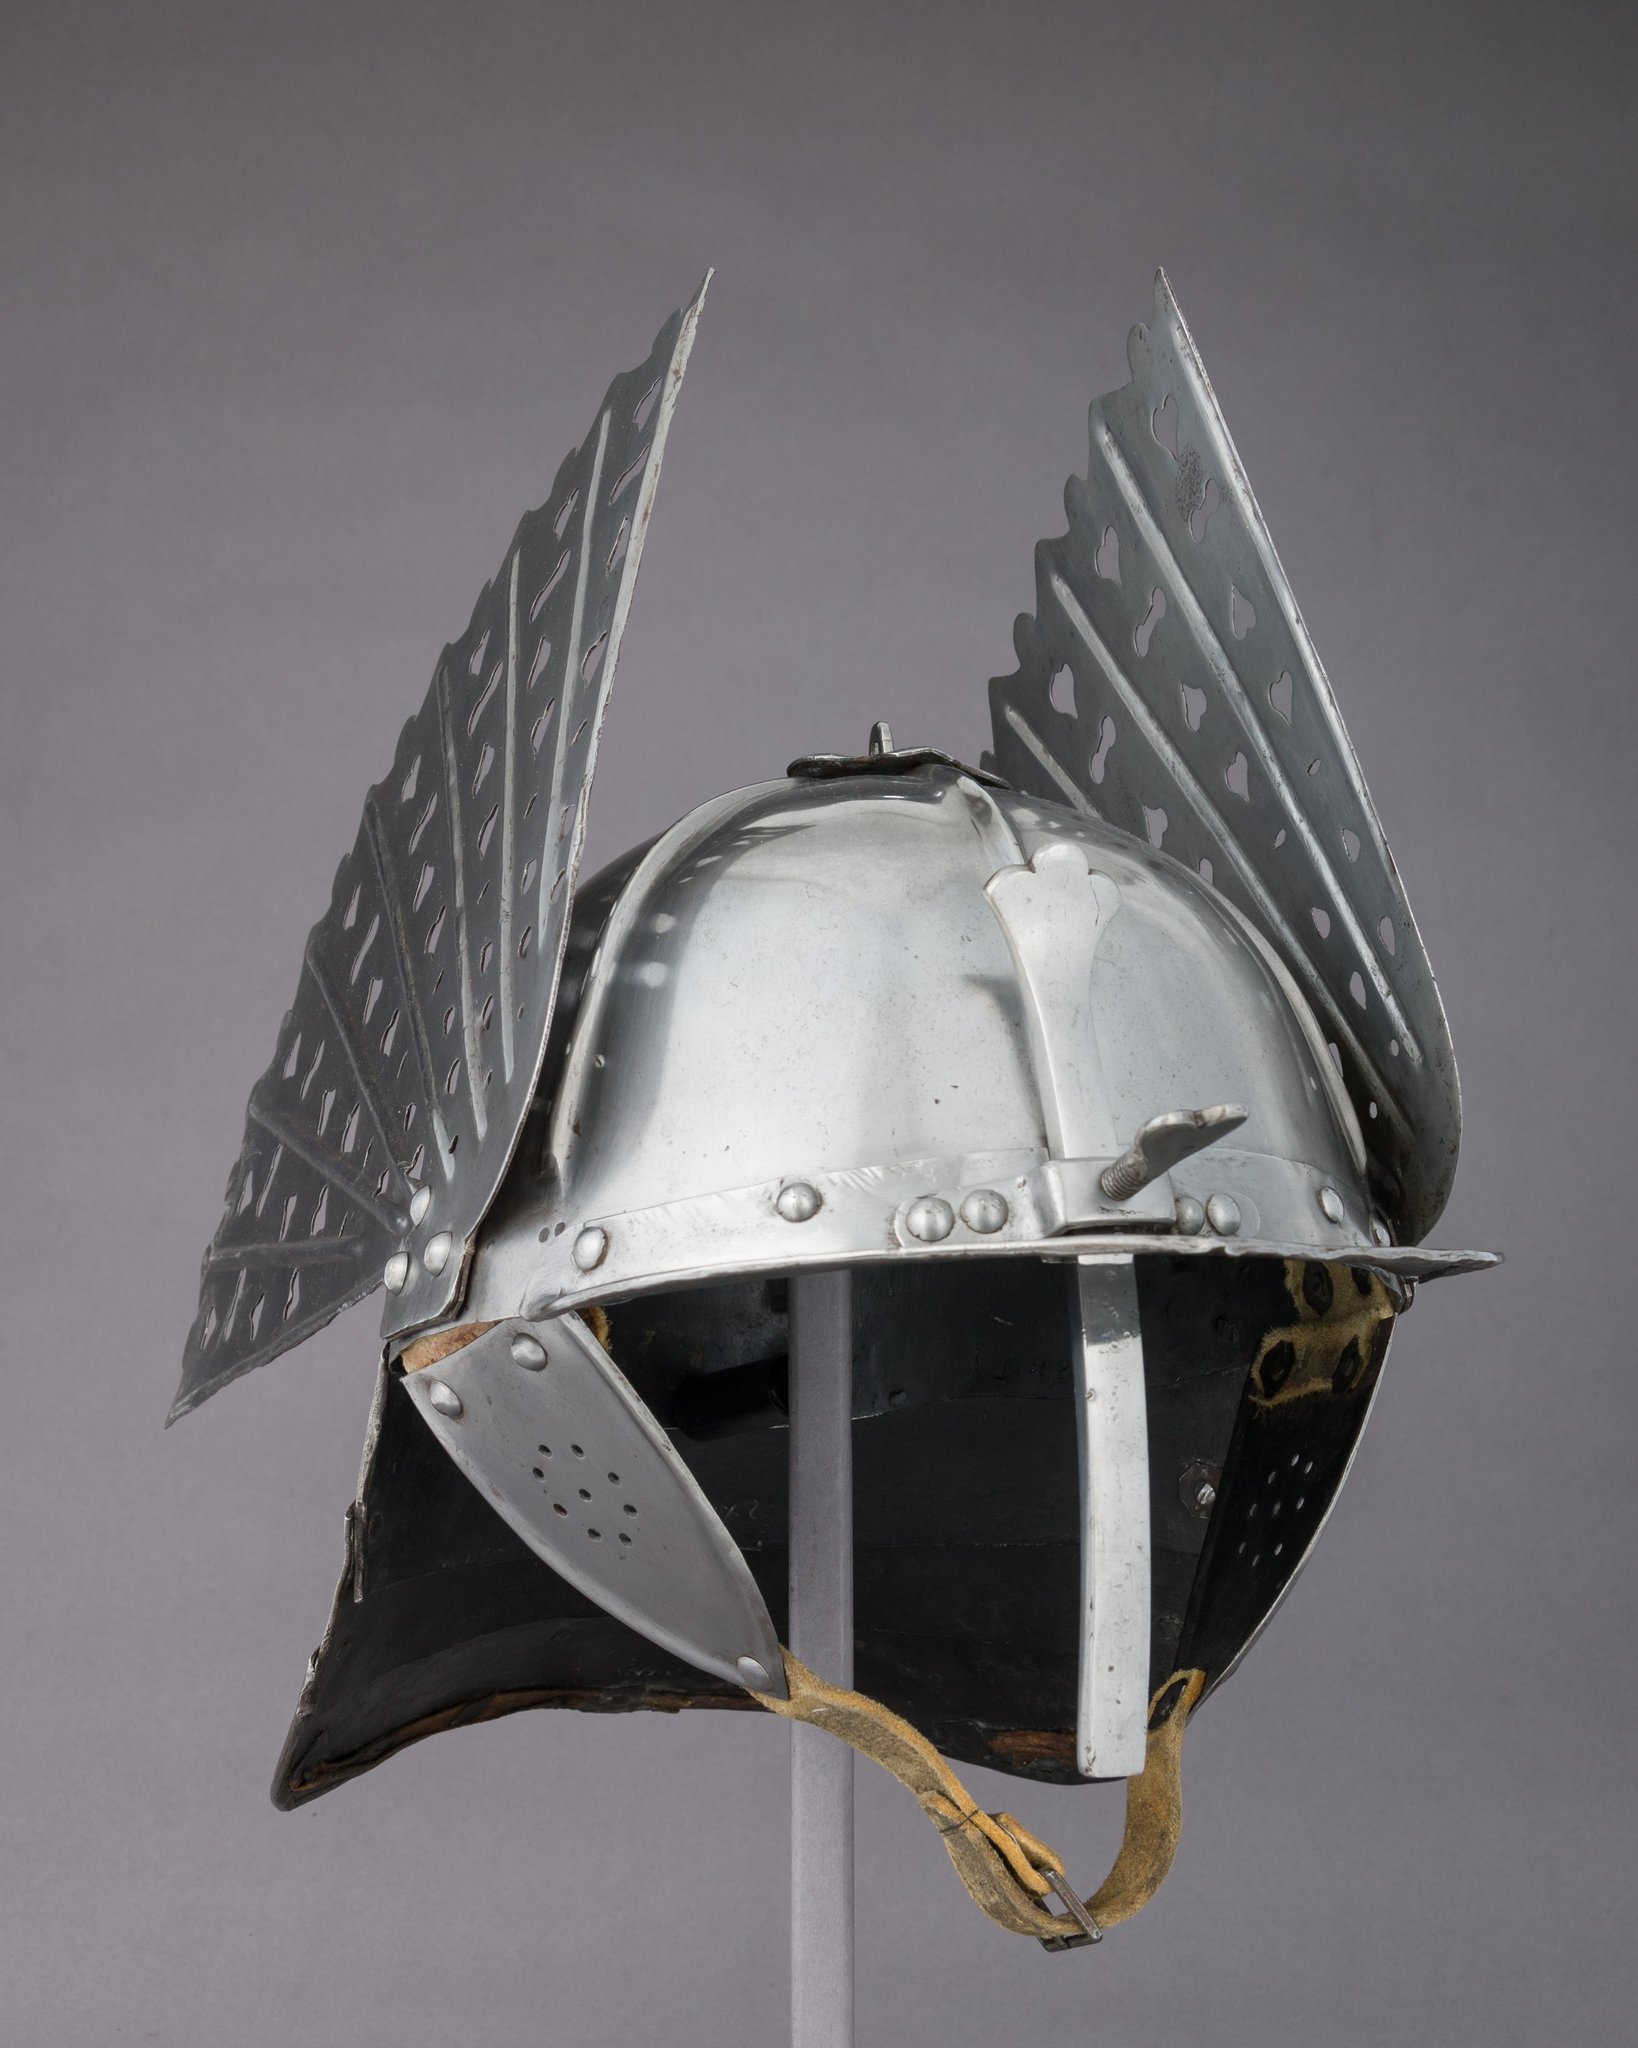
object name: lobster tail burgonet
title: Lobster-Tail Burgonet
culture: polish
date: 1601-1700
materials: leather, steel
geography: poland